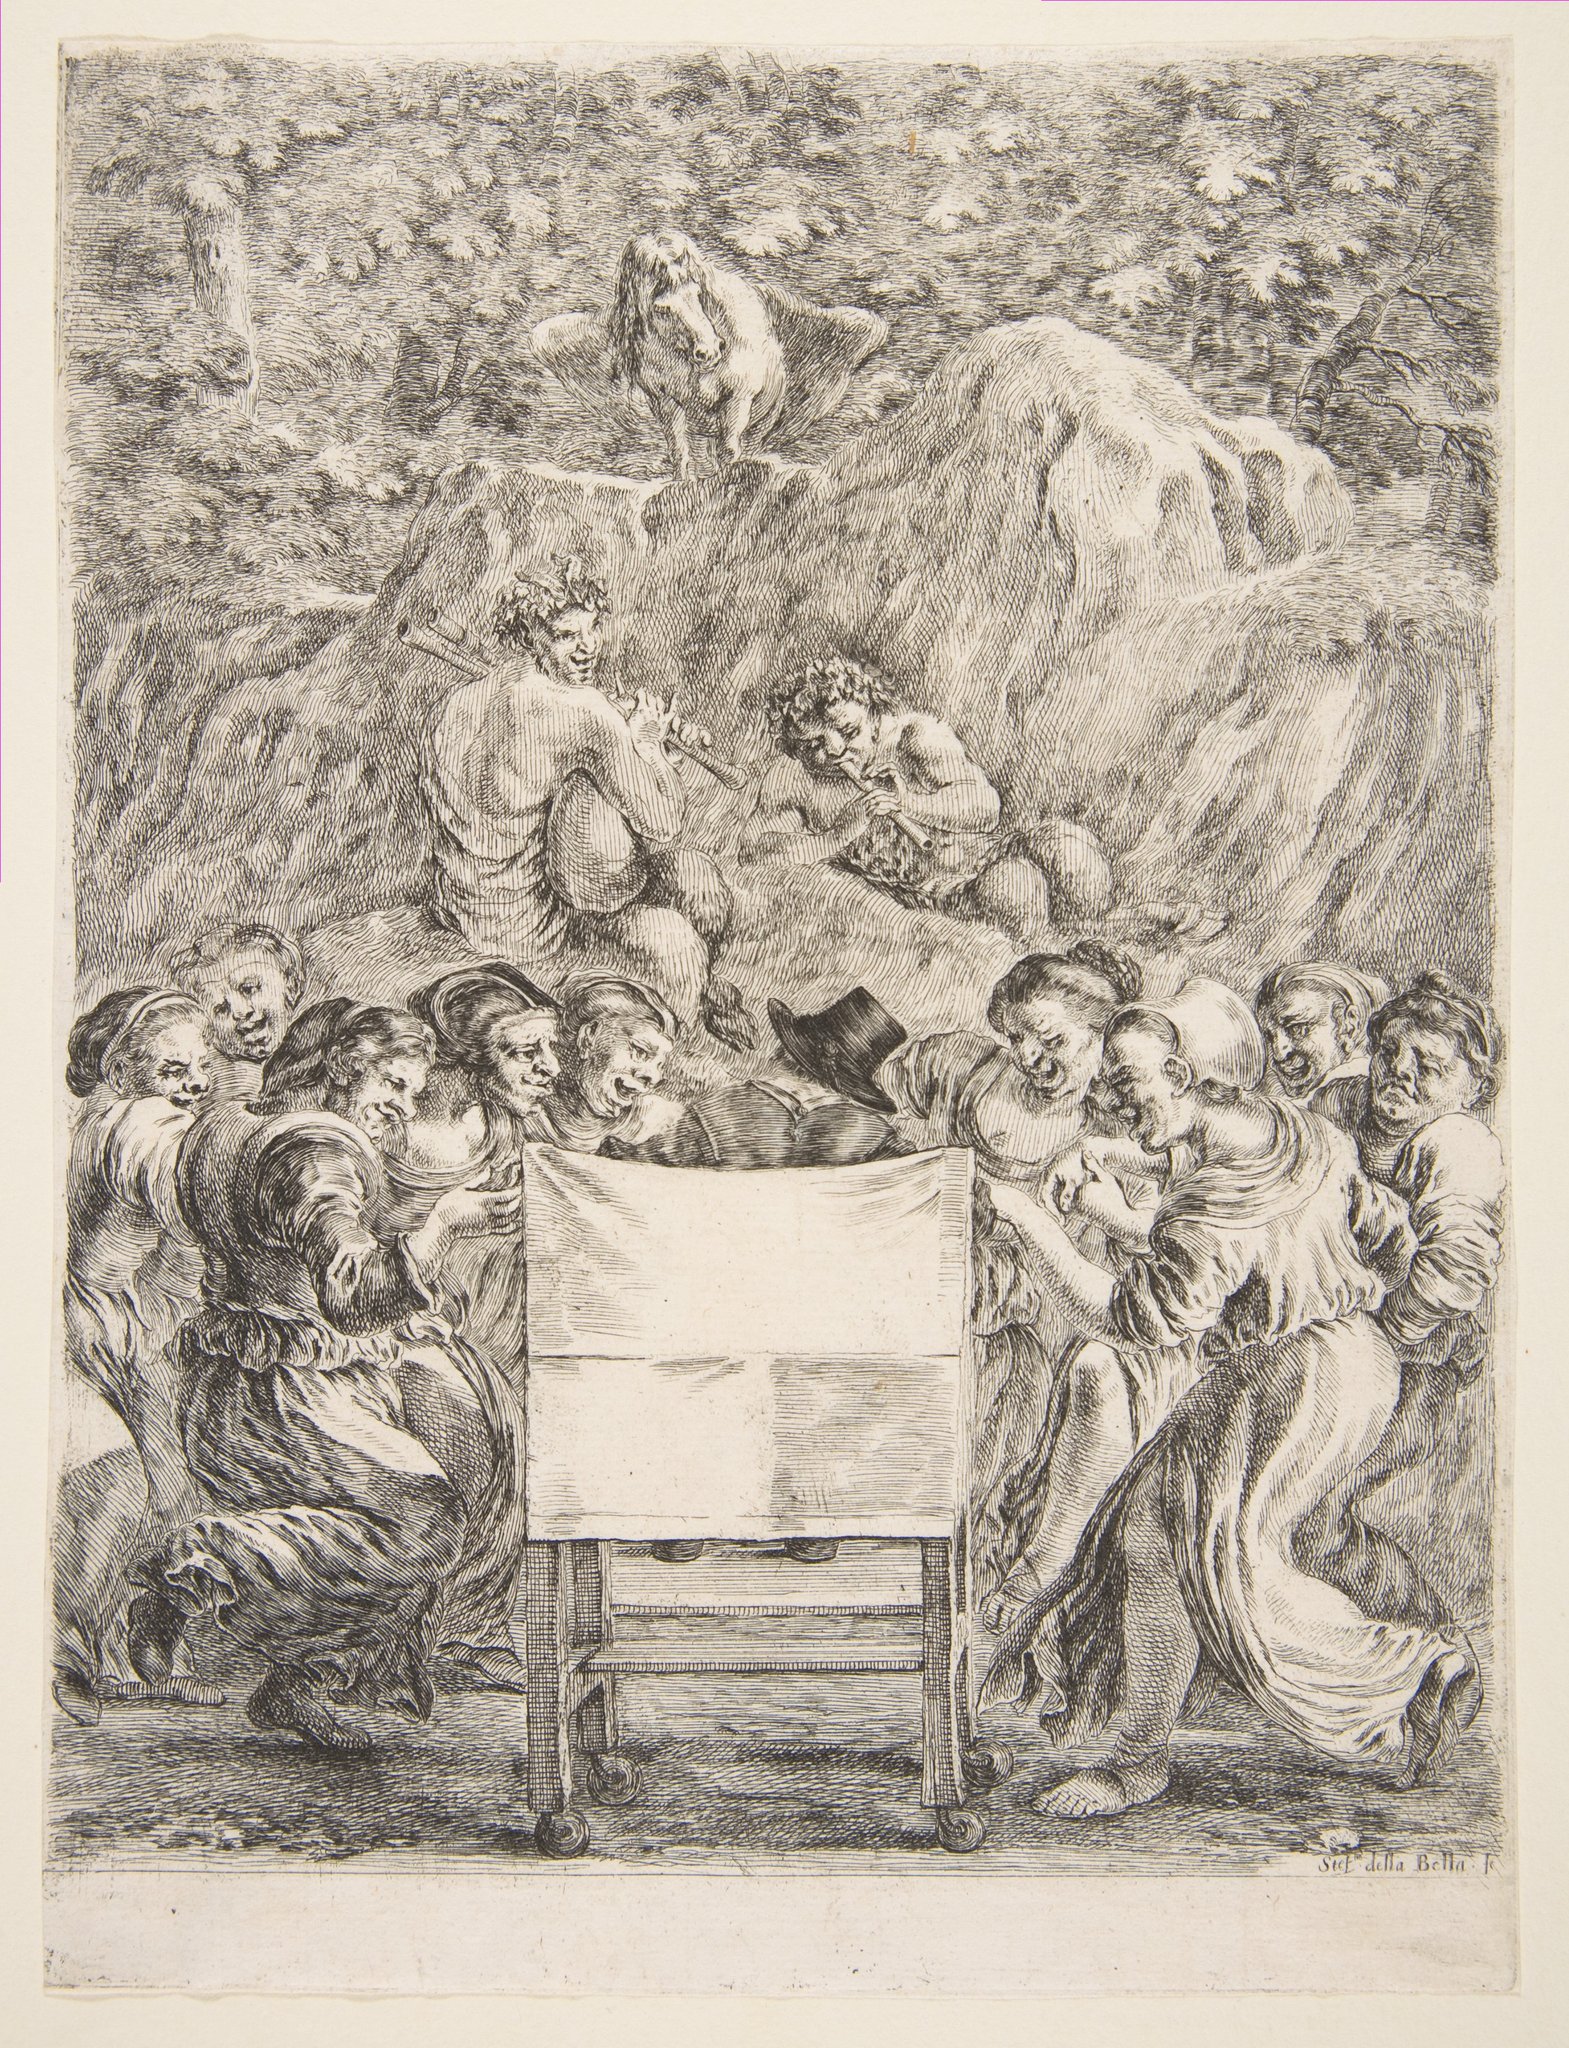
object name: print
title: Parnassus, frontispiece to Les Oeuvres de Scarron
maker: stefano della bella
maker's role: artist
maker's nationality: italian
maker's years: 1610-1664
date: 1649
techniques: etching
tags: animals,men,women